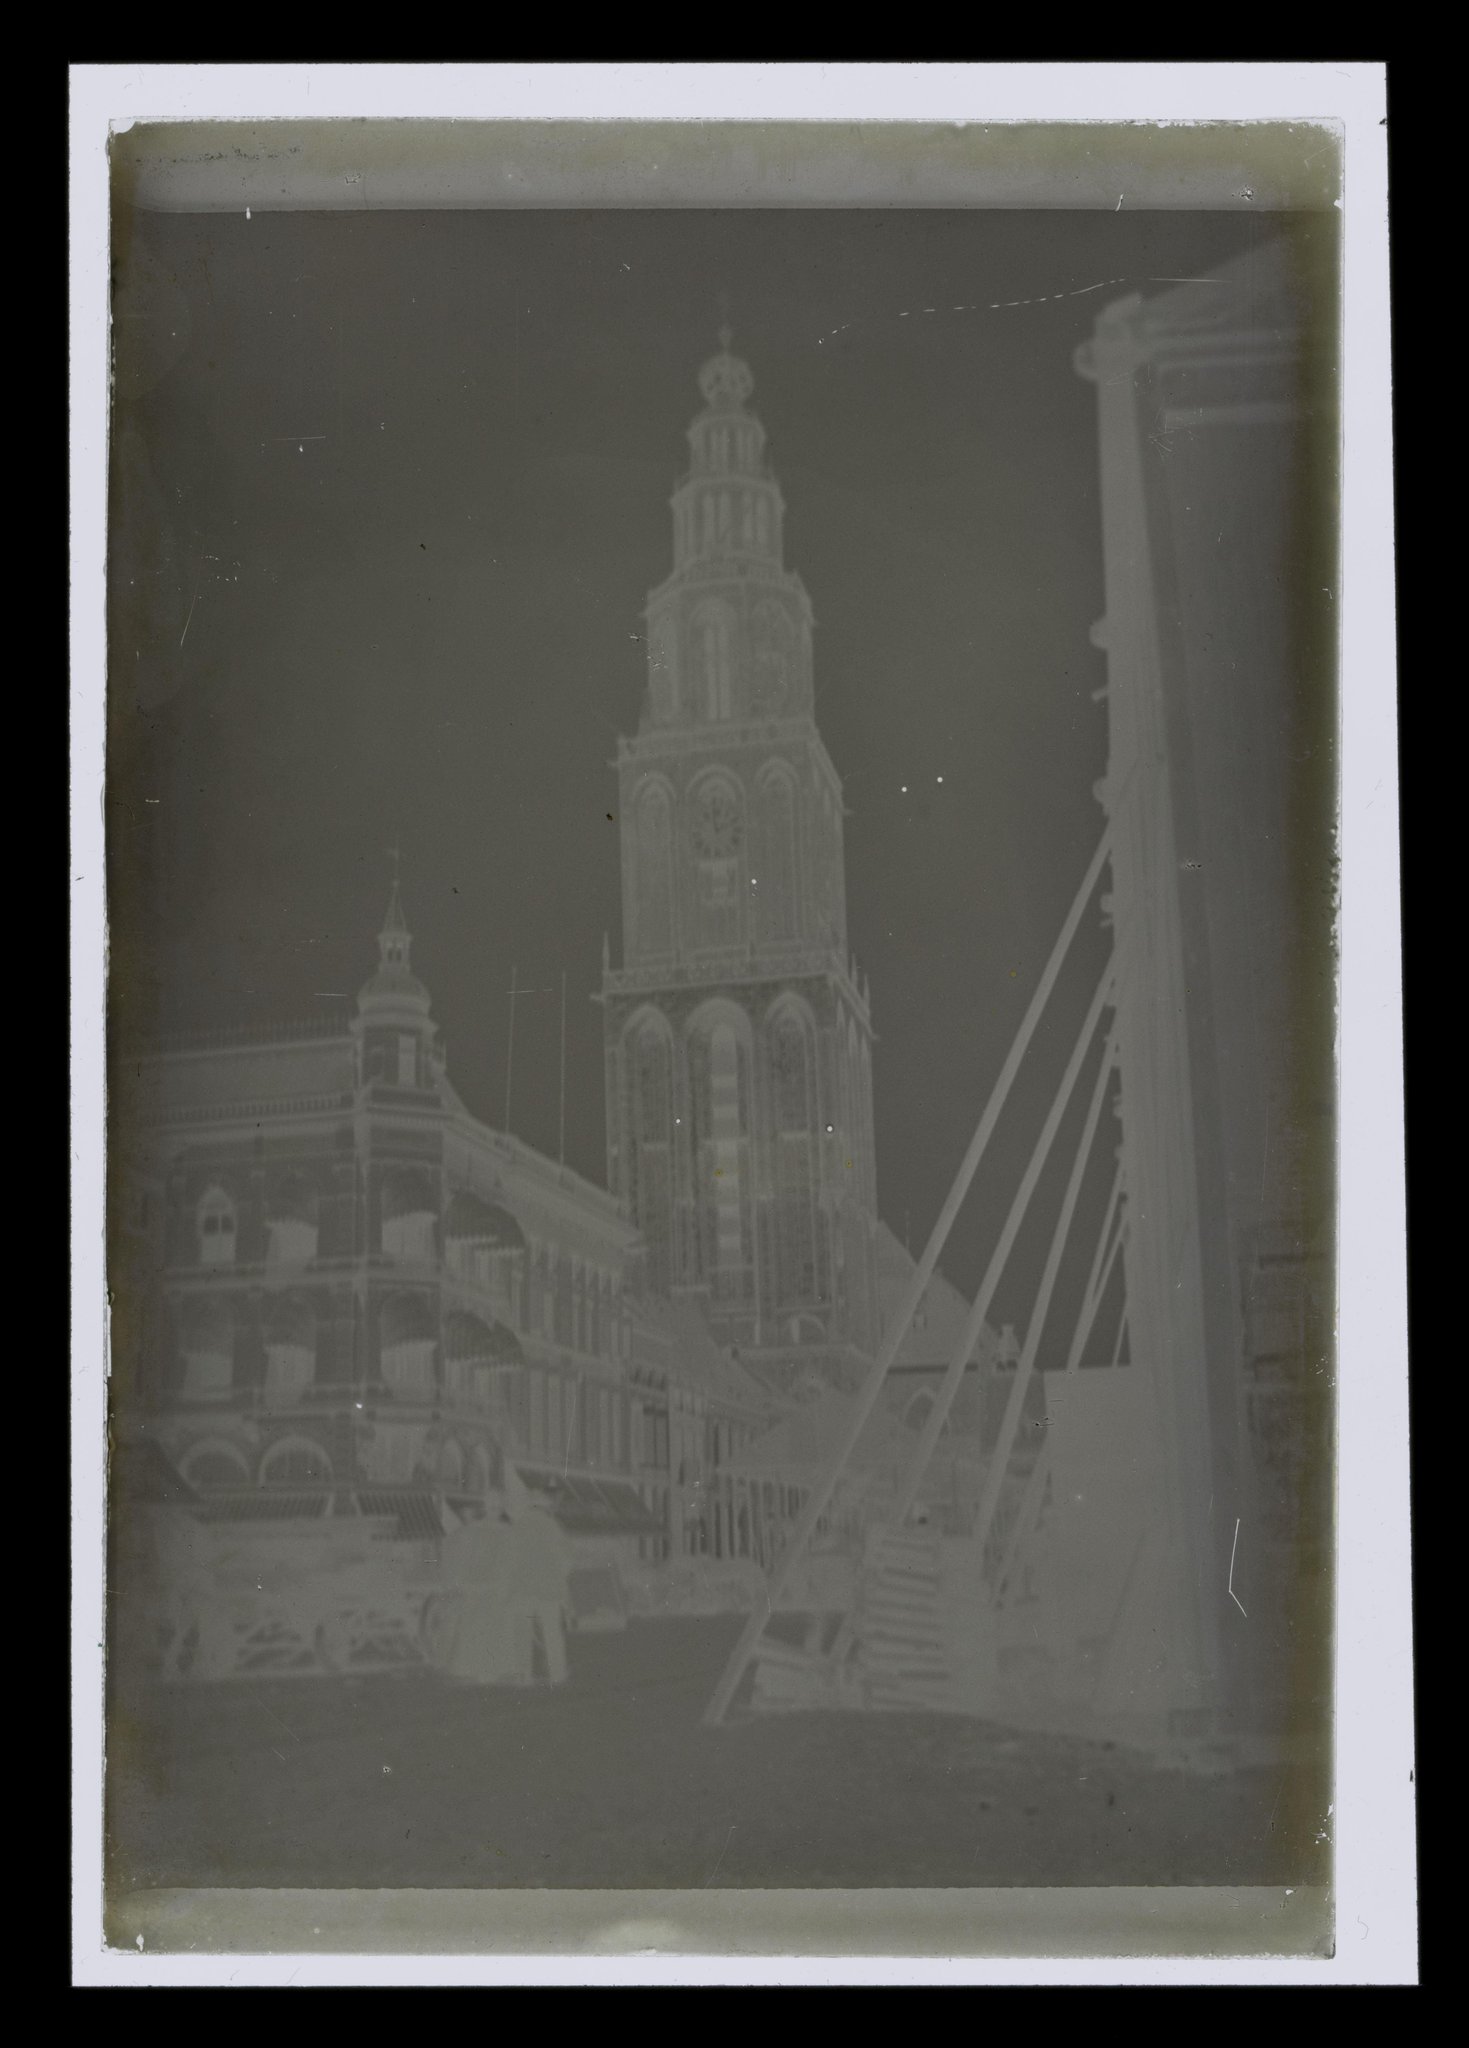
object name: glasnegatief, glasplaatnegatief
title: Gezicht op de Martinitoren vanaf Tussen beide Markten, Groningen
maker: laurens lodewijk kleijn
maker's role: draughtsman, painter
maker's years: 1826-1909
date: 1865-1900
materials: glass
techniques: collodion process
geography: groningen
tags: square, place, circus, etc., façade (of house or building), parts of church exterior and annexes: tower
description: Onderdeel van groep glasnegatieven uit de nalatenschap van de schilder Laurens Lodewijk Kleijn, stillevens, portretten, zelfportretten en kunstreproducties.